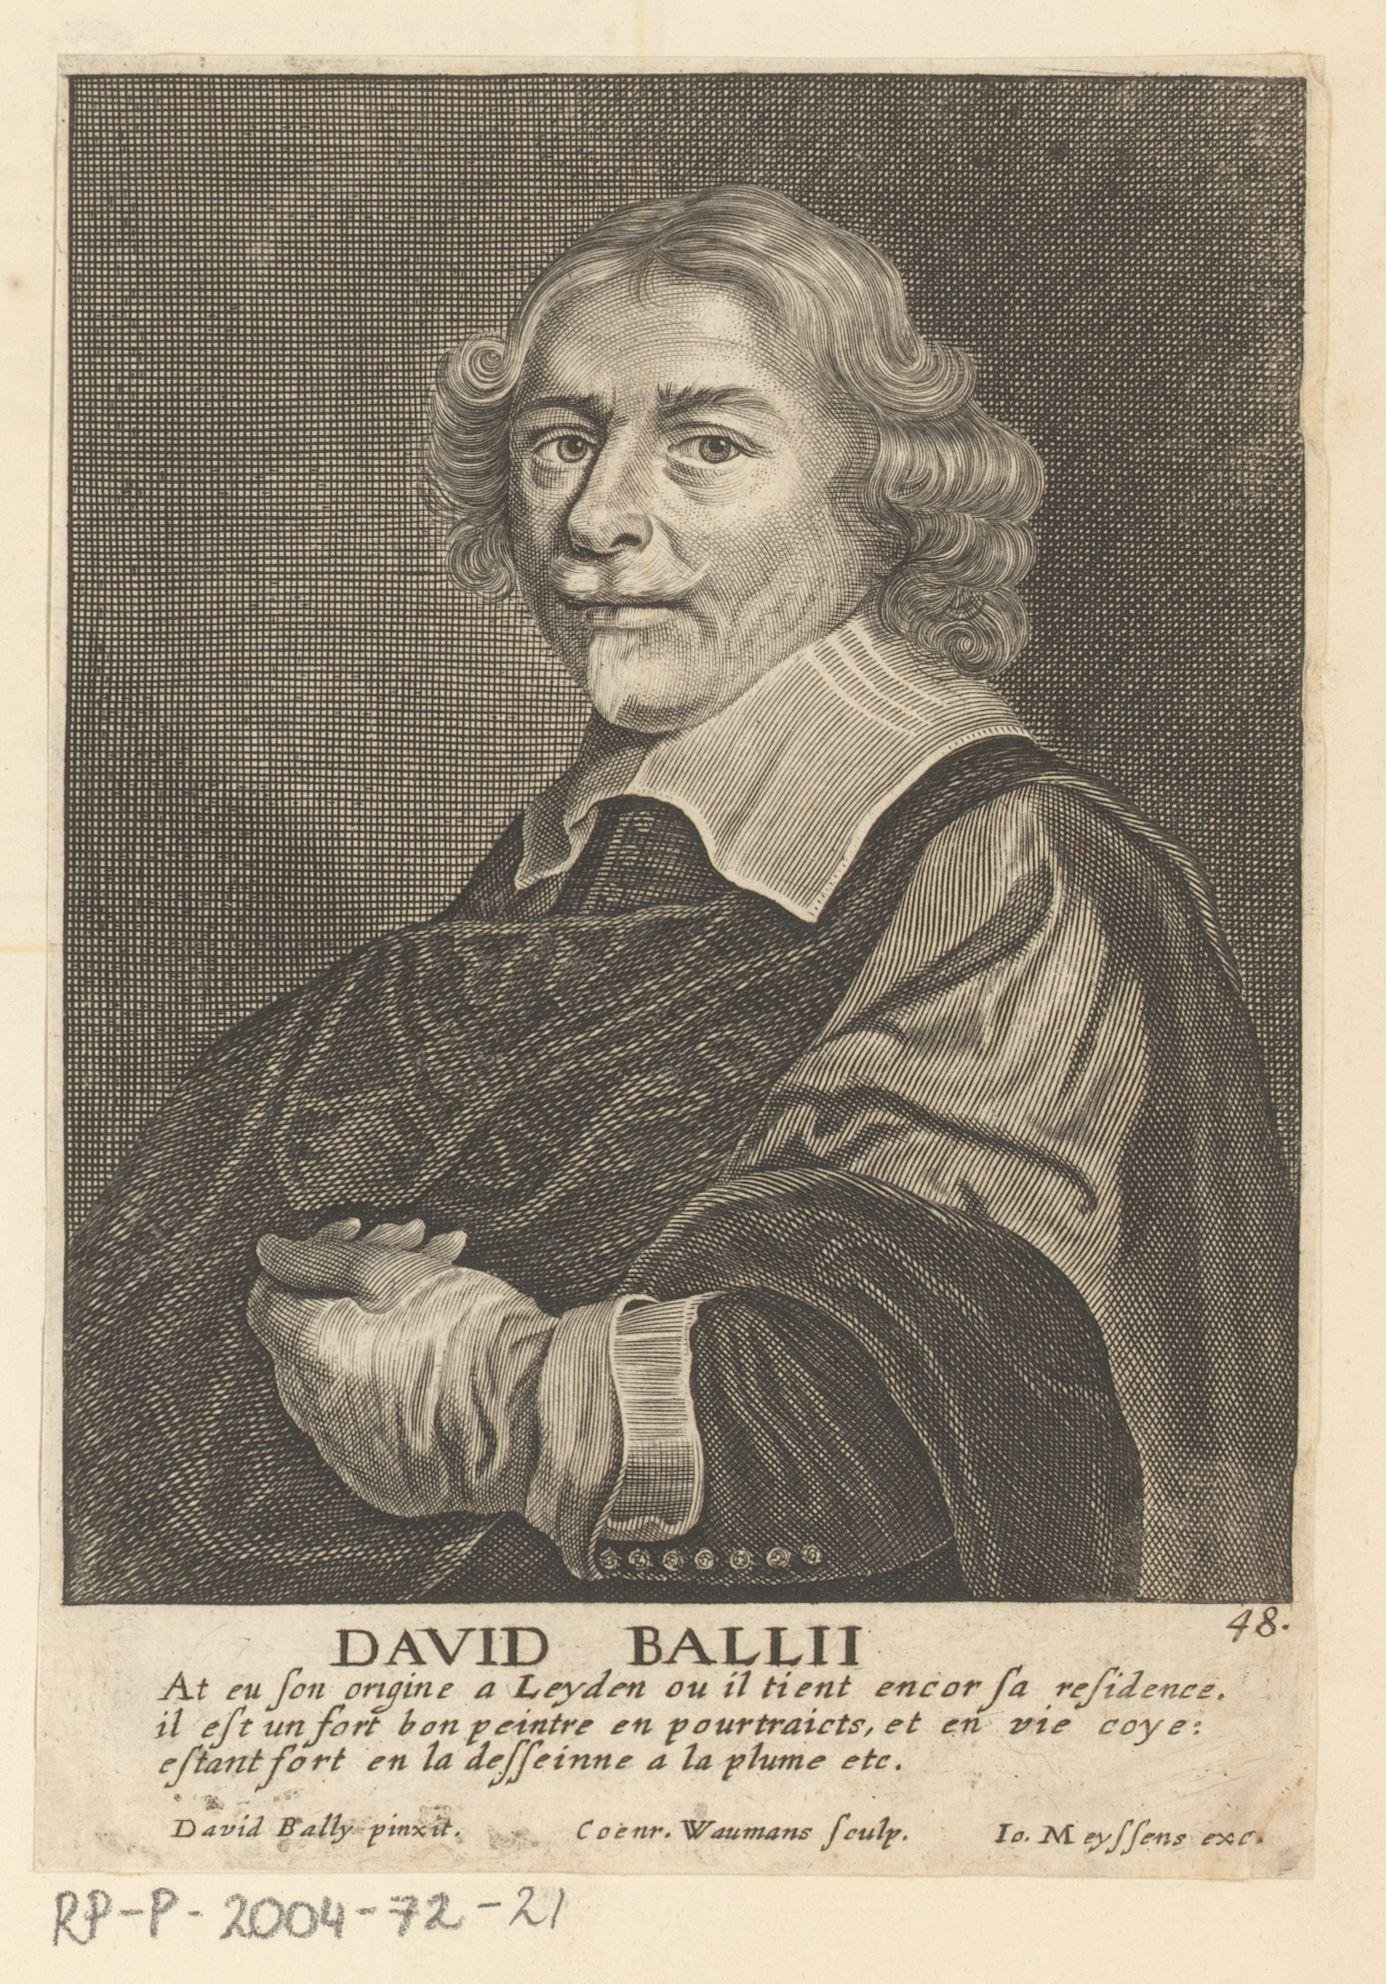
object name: album leaf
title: Portret van David Bailly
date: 1649-1662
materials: paper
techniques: engraving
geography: antwerp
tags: leiden, draughtsman, david bailly, historical persons, portrait, self-portrait of painter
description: Prent mogelijk uit: Meyssens, Joannes. Image de divers hommes desprit sublime qui par leur art et science deburovent vivre eternellement et des quels la louange et renommée faict estonner le monde. Antwerpen: Joannes Meyssens, 1649, dl. 1, p. 71. Andere staat van prent gebruikt in: Bie, Cornelis De. Het gulden Cabinet vande edel vry schilder const, inhoudende den lof vande vermarste schilders, architecte, beldthowers ende plaetsnyders van dese eeuw. Antwerpen: Joannes Meyssens, 1662 [1661 foutief op titelpagina], p. 271. De samensteller heeft deze prent in het album geplakt als illustratie bij: Pilkington, Matthew en Johann Heinrich Füssli. A dictionary of painters, from the revival of the art to the present period. 4 dln. Londen: John Crowder, 1805, dl. 1, p. 24.